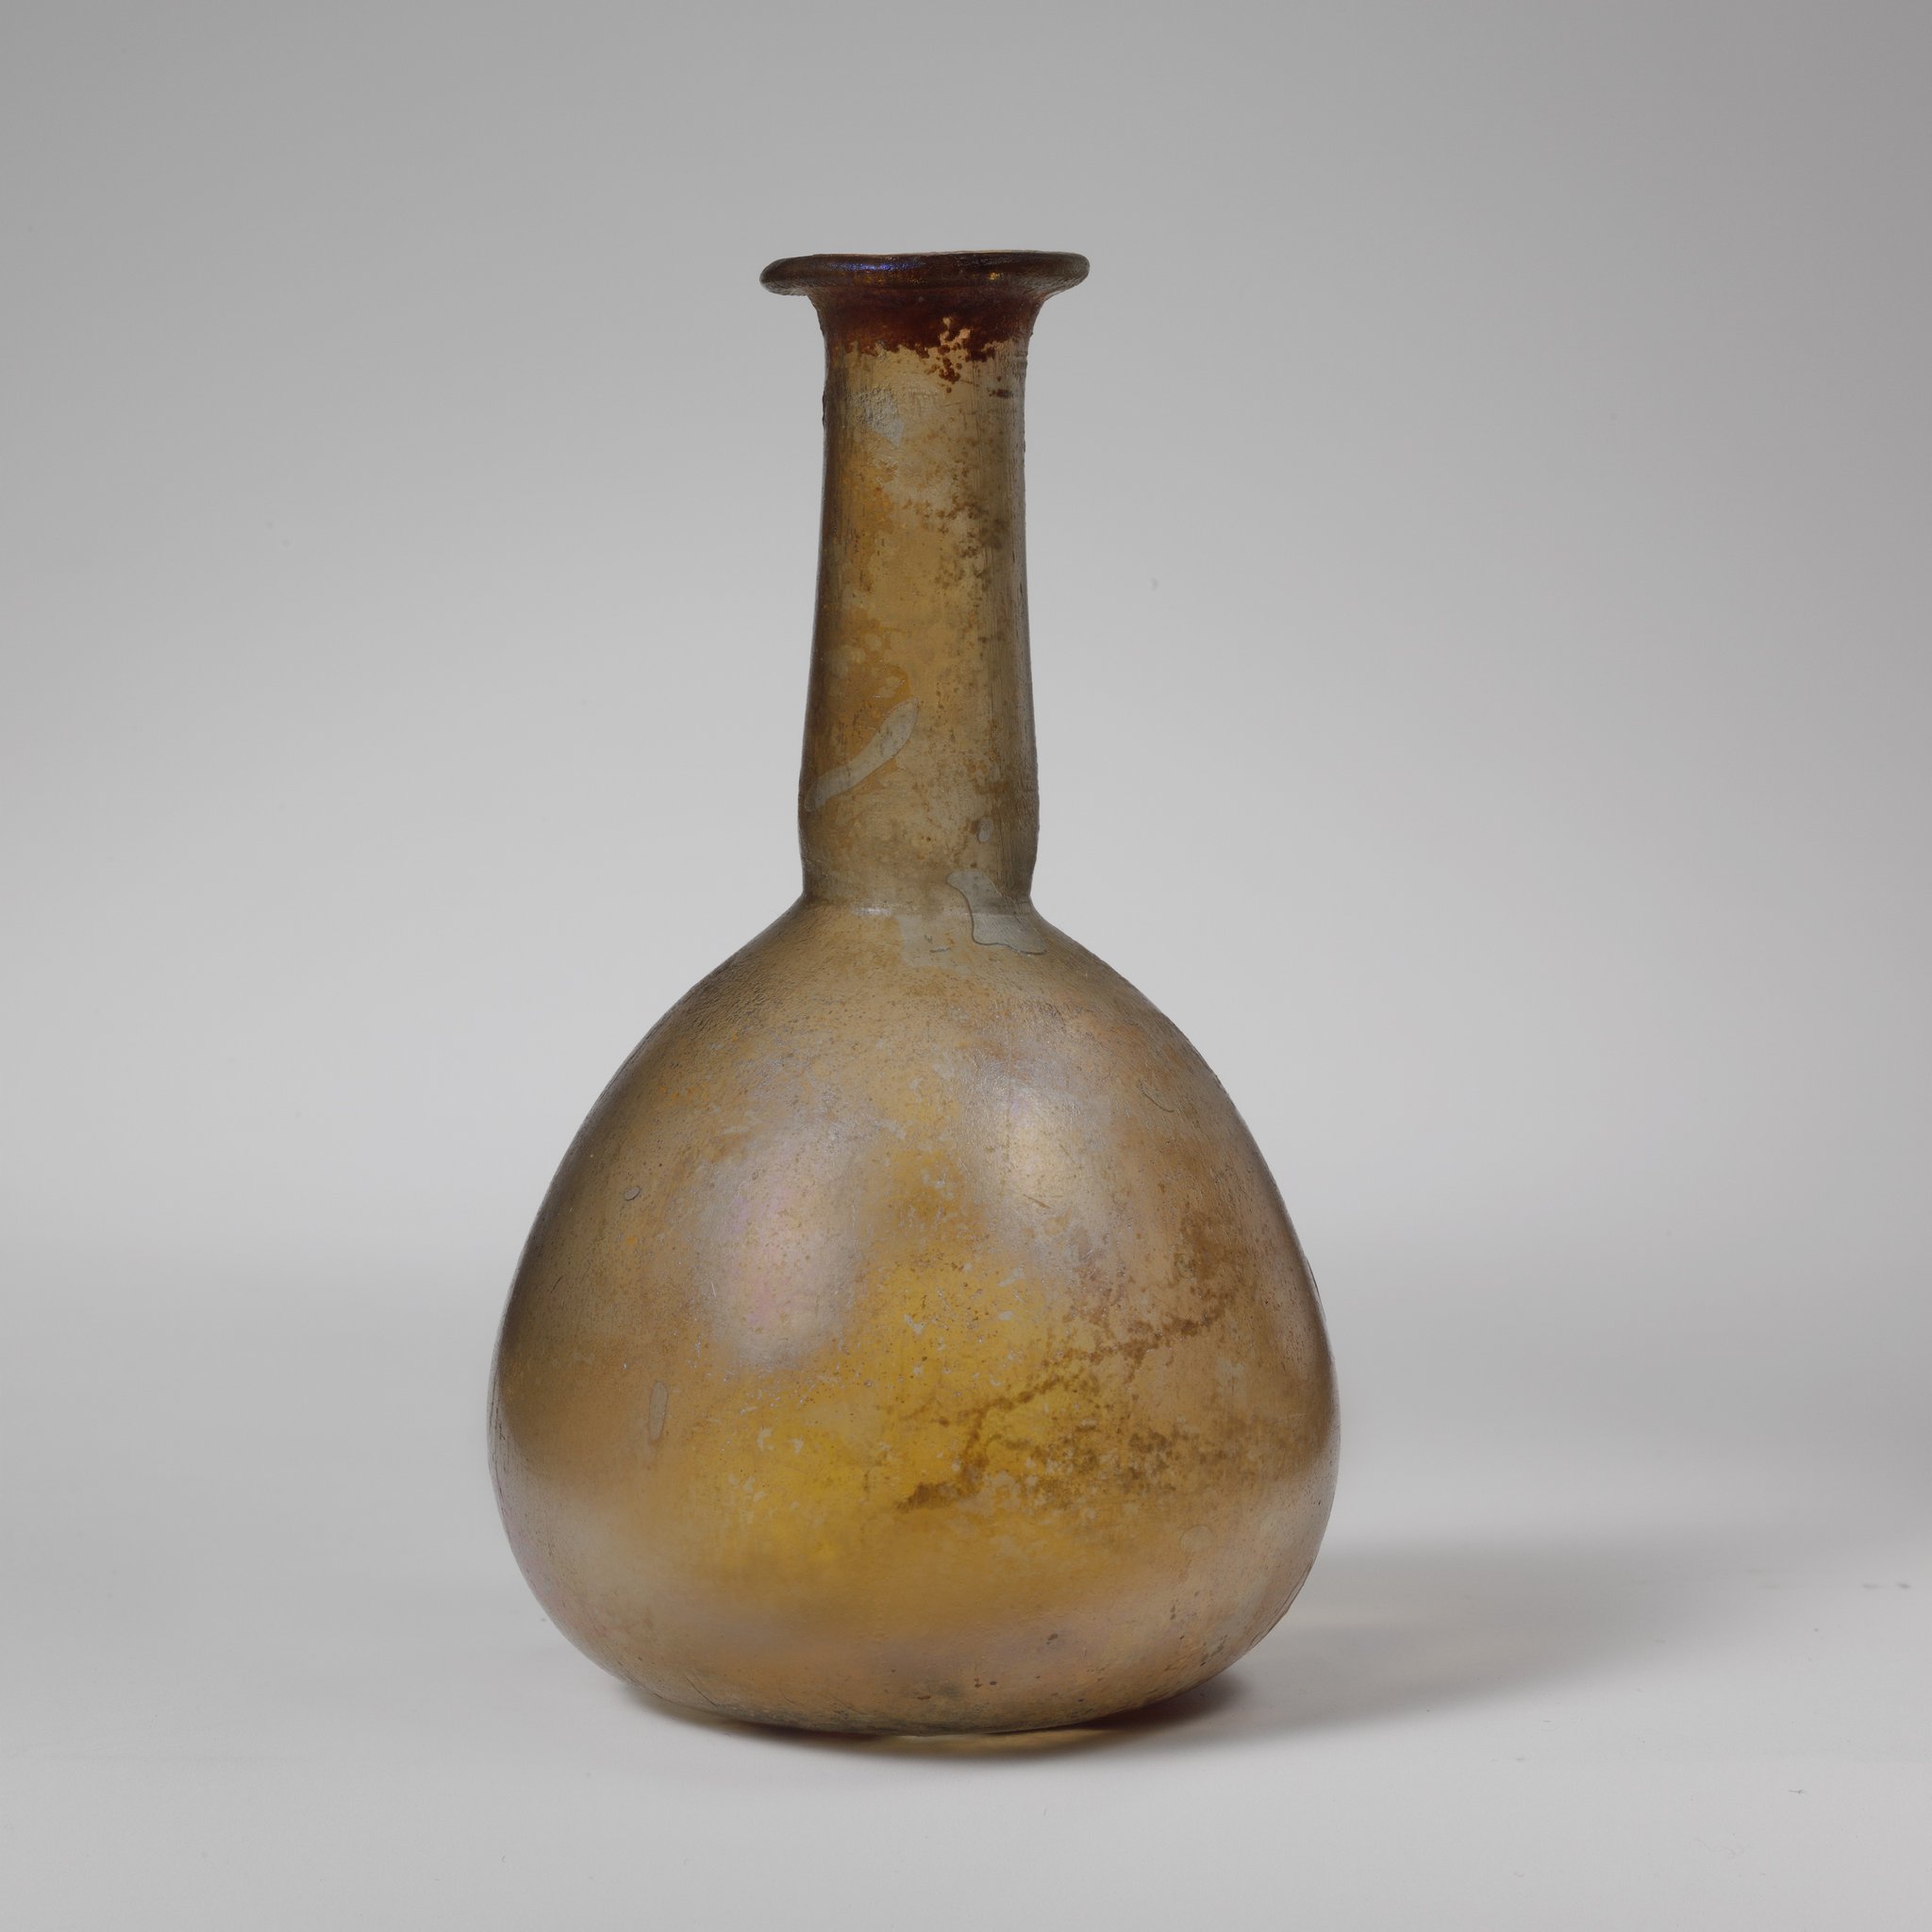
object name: perfume bottle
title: Glass perfume bottle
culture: roman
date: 1-200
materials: glass